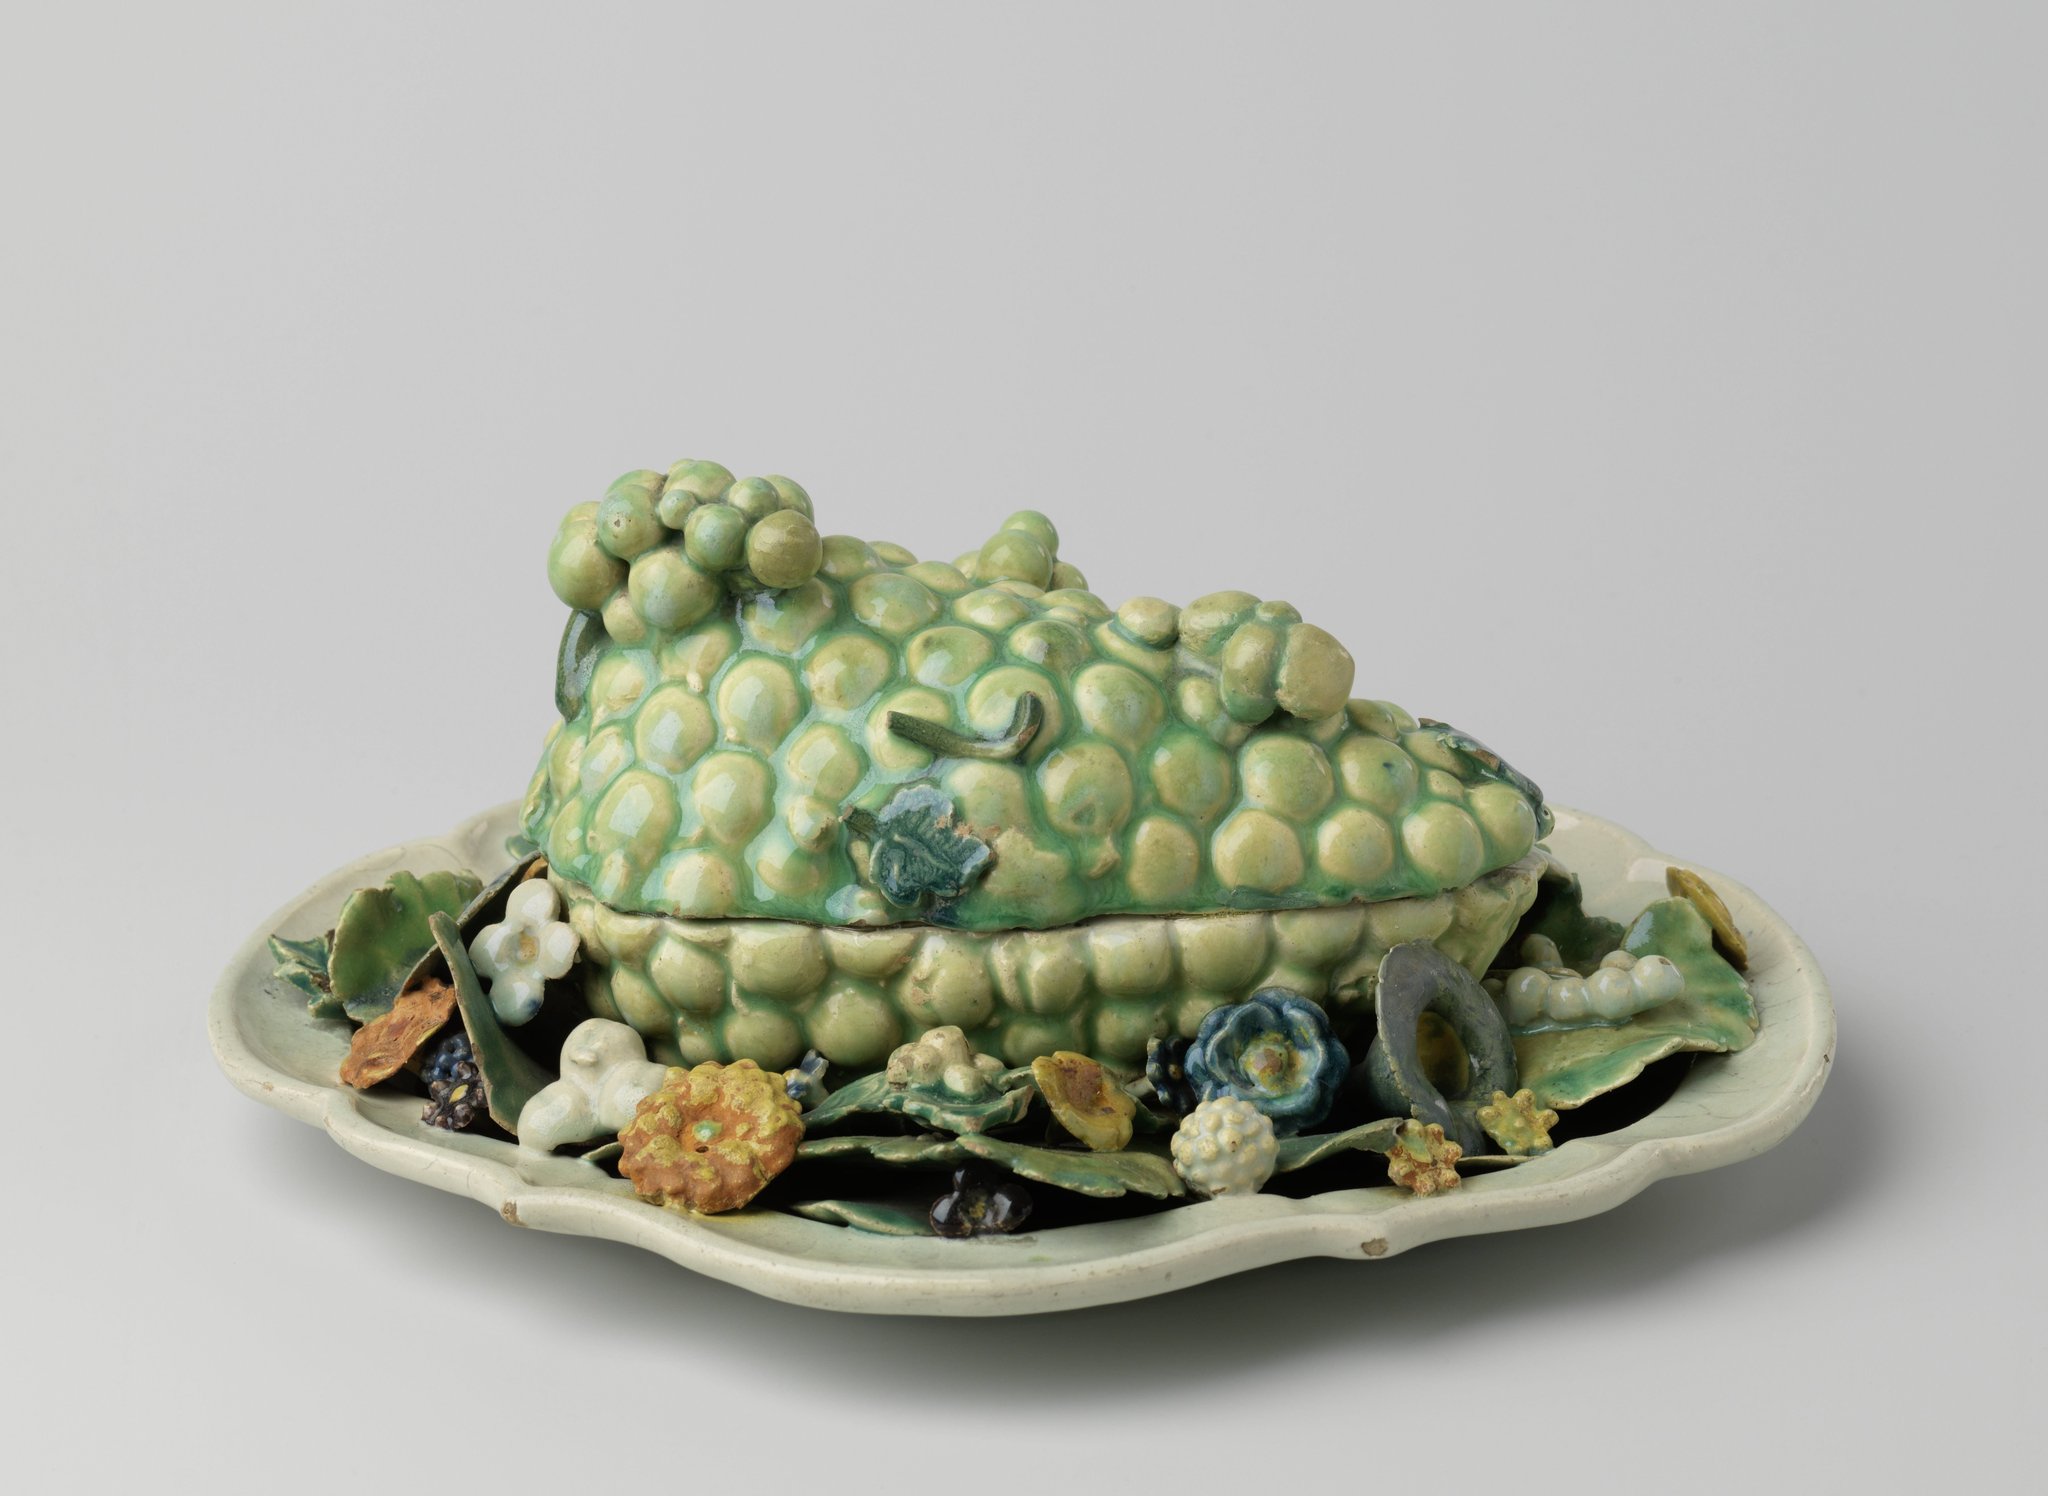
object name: butter dish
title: Botervloot in de vorm van een witte druiventros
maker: arie blankers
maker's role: plateelbakker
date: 1756-1764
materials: earthenware, glaze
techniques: painted, polychromy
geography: amsterdam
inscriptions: mark: ‘A B’, mark: ‘A B’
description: Botervloot van veelkleurig beschilderde faience. De botervloot heeft de vorm van een witte druiventros, liggend op een bed van bloemen en bladeren op een schaal. De botervloot heeft een deksel en een binnenbak. De deksel en de bak zijn gemerkt.